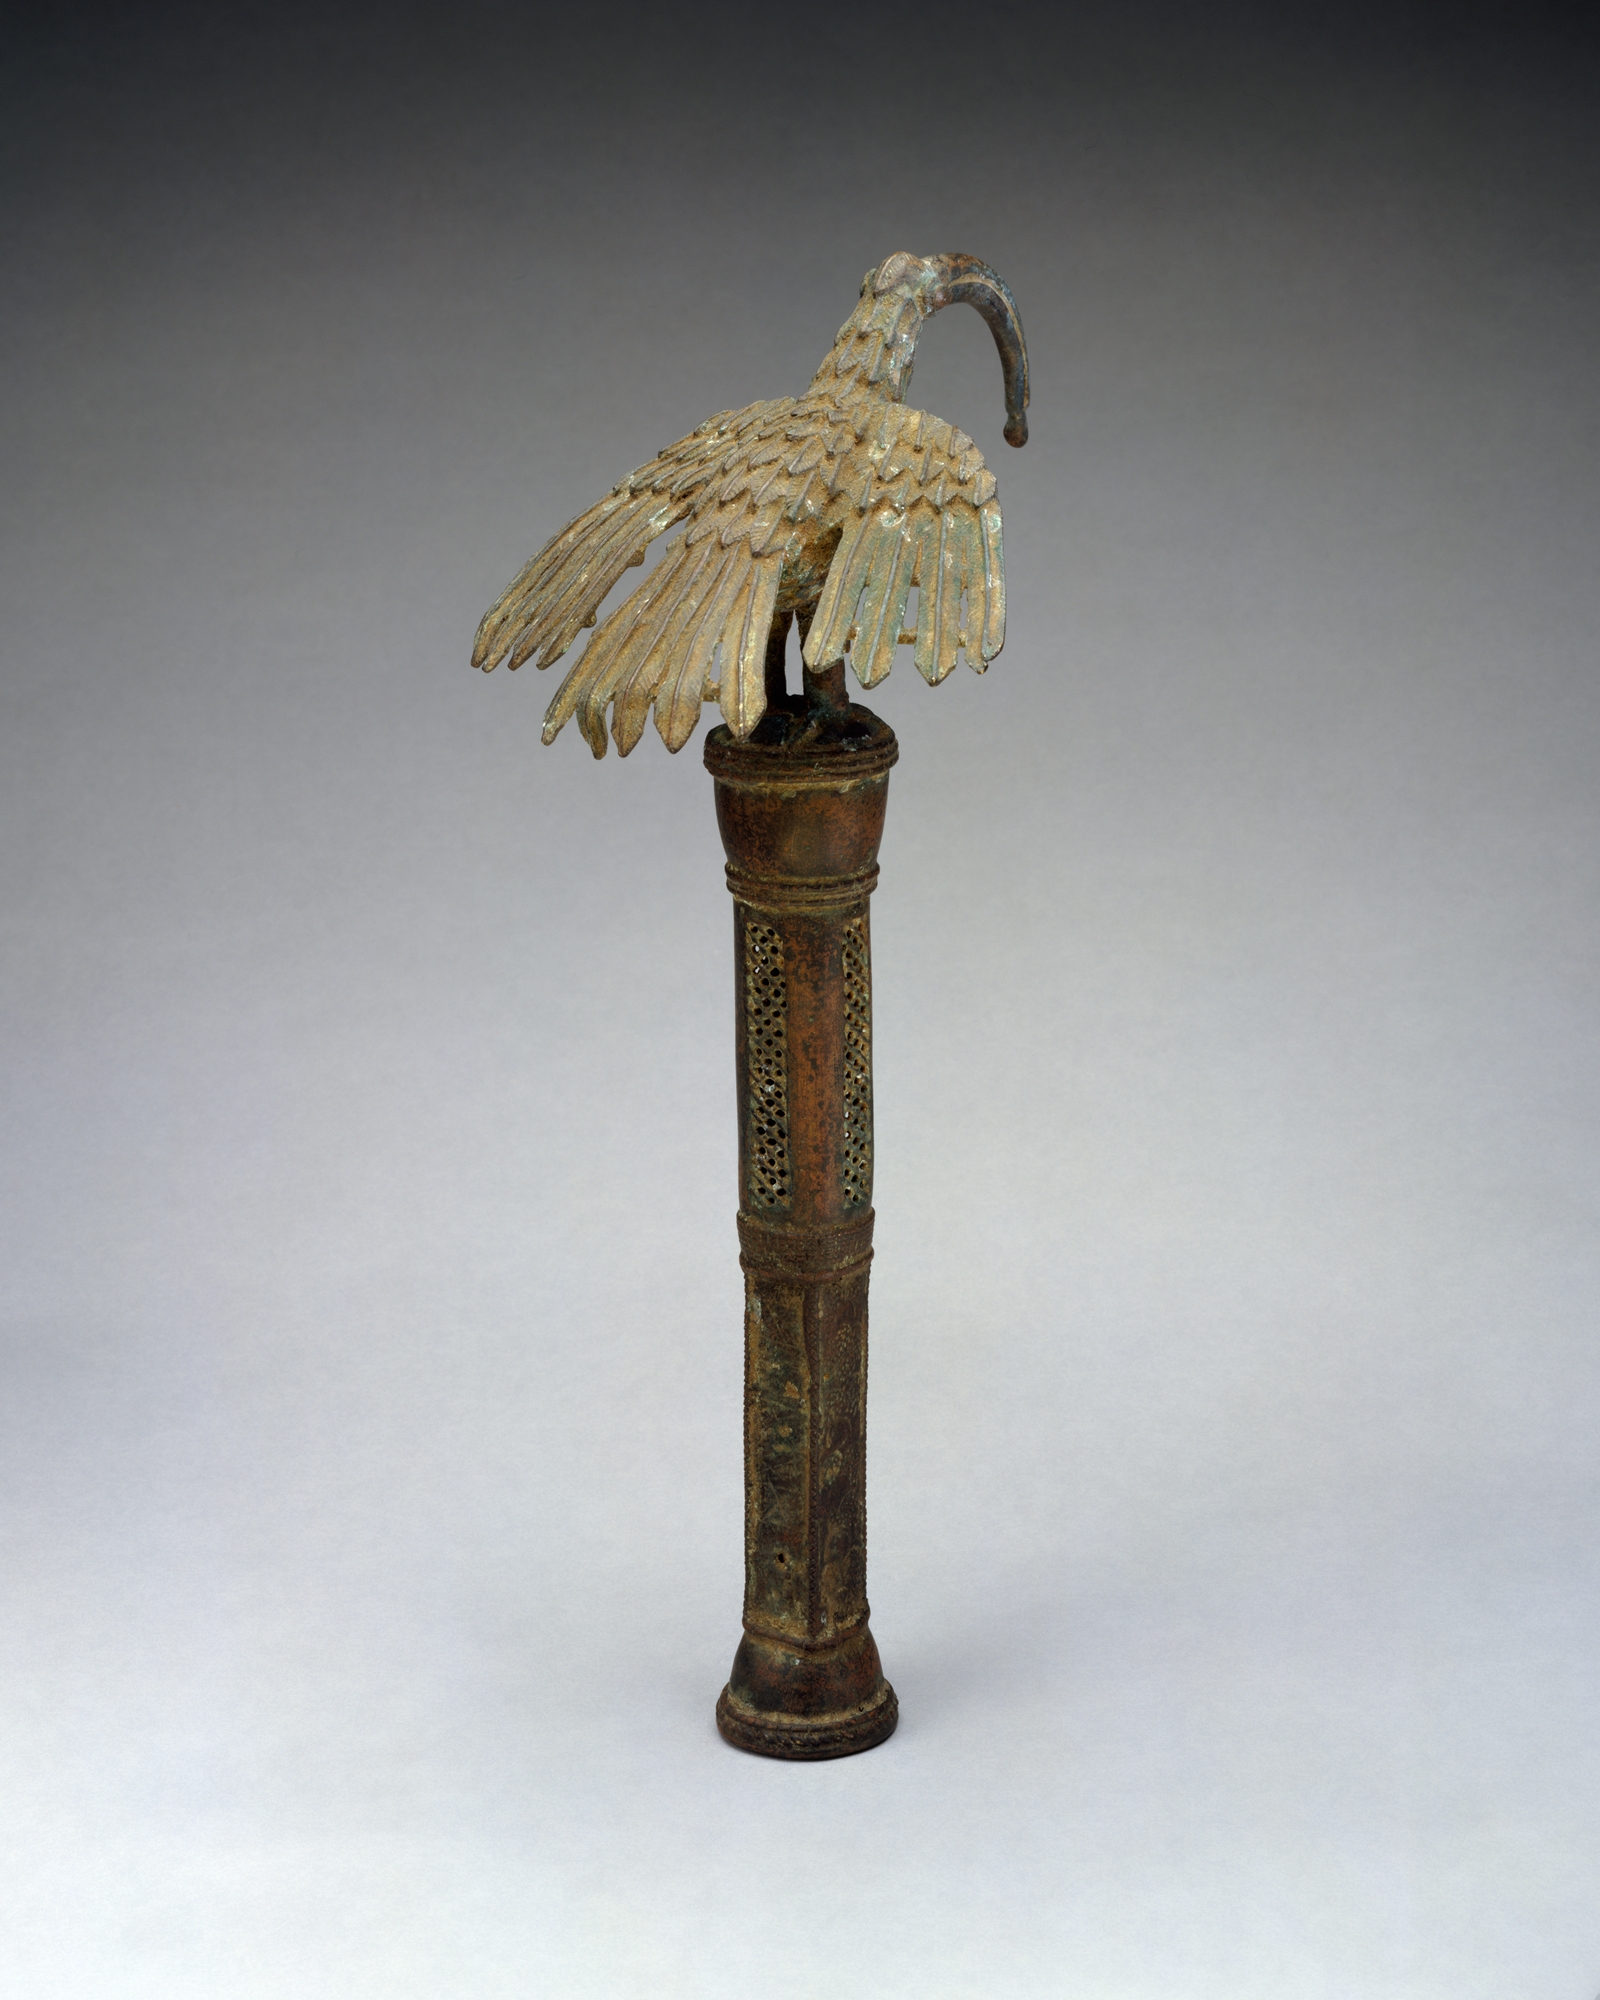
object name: idiophone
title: Idiophone: Bird of Prophecy (ahianmwen-oro)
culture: edo period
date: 1501-1900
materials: brass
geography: nigeria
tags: birds